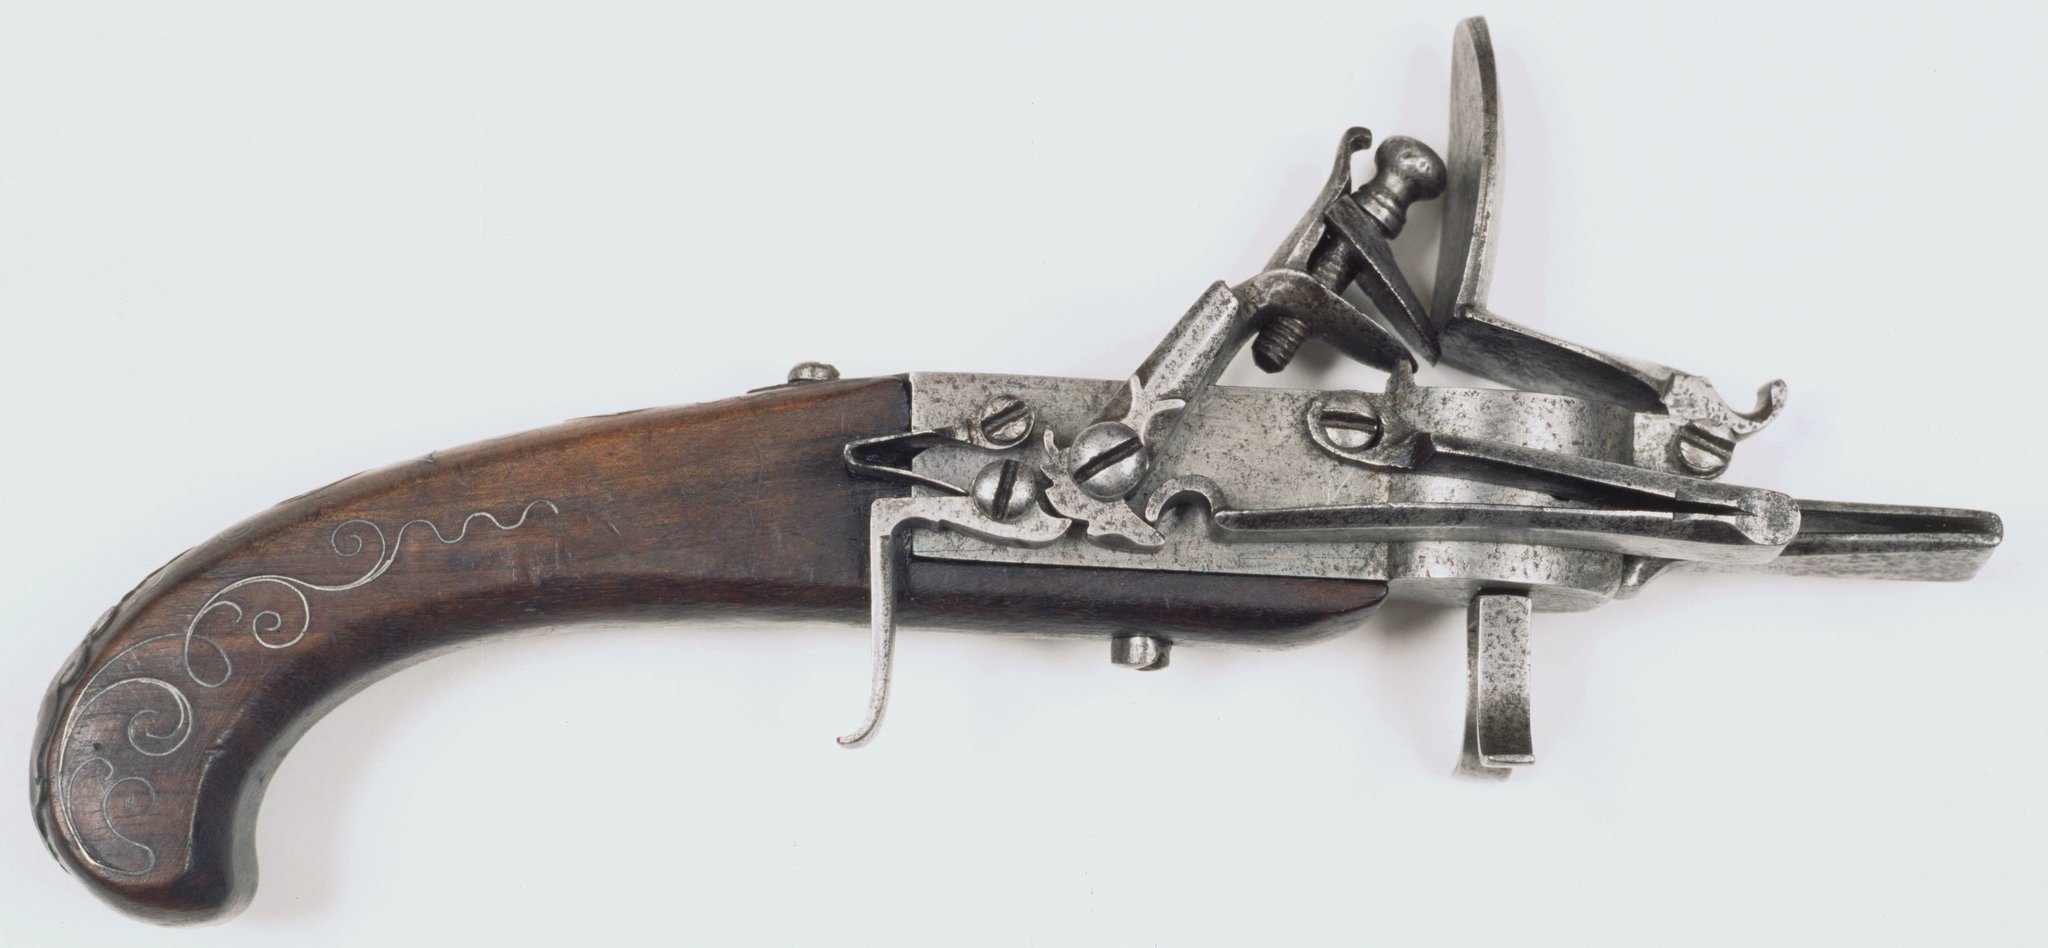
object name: tinder box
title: Pistool-tondeldoos met vuursteenslot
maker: Anonymous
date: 1750-1800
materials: iron, thread, wood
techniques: inlay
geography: western europe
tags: netherlands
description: Tondeldoos met ijzeren slotplaat waarvan de linkerzijde geopend kan worden, pan met vuurstaal bevinden zich voor de ijzeren haan. De kolf is van hout en versierd met verschillende krullende motieven van zilverdraad. Geen trekkerbeugel, de trekker bevindt zich naast de lade en is heeft een rechtsteekse verbinding met het slot. Onder de slotplaat twee voetstukken waarop de tondeldoos kan rusten.